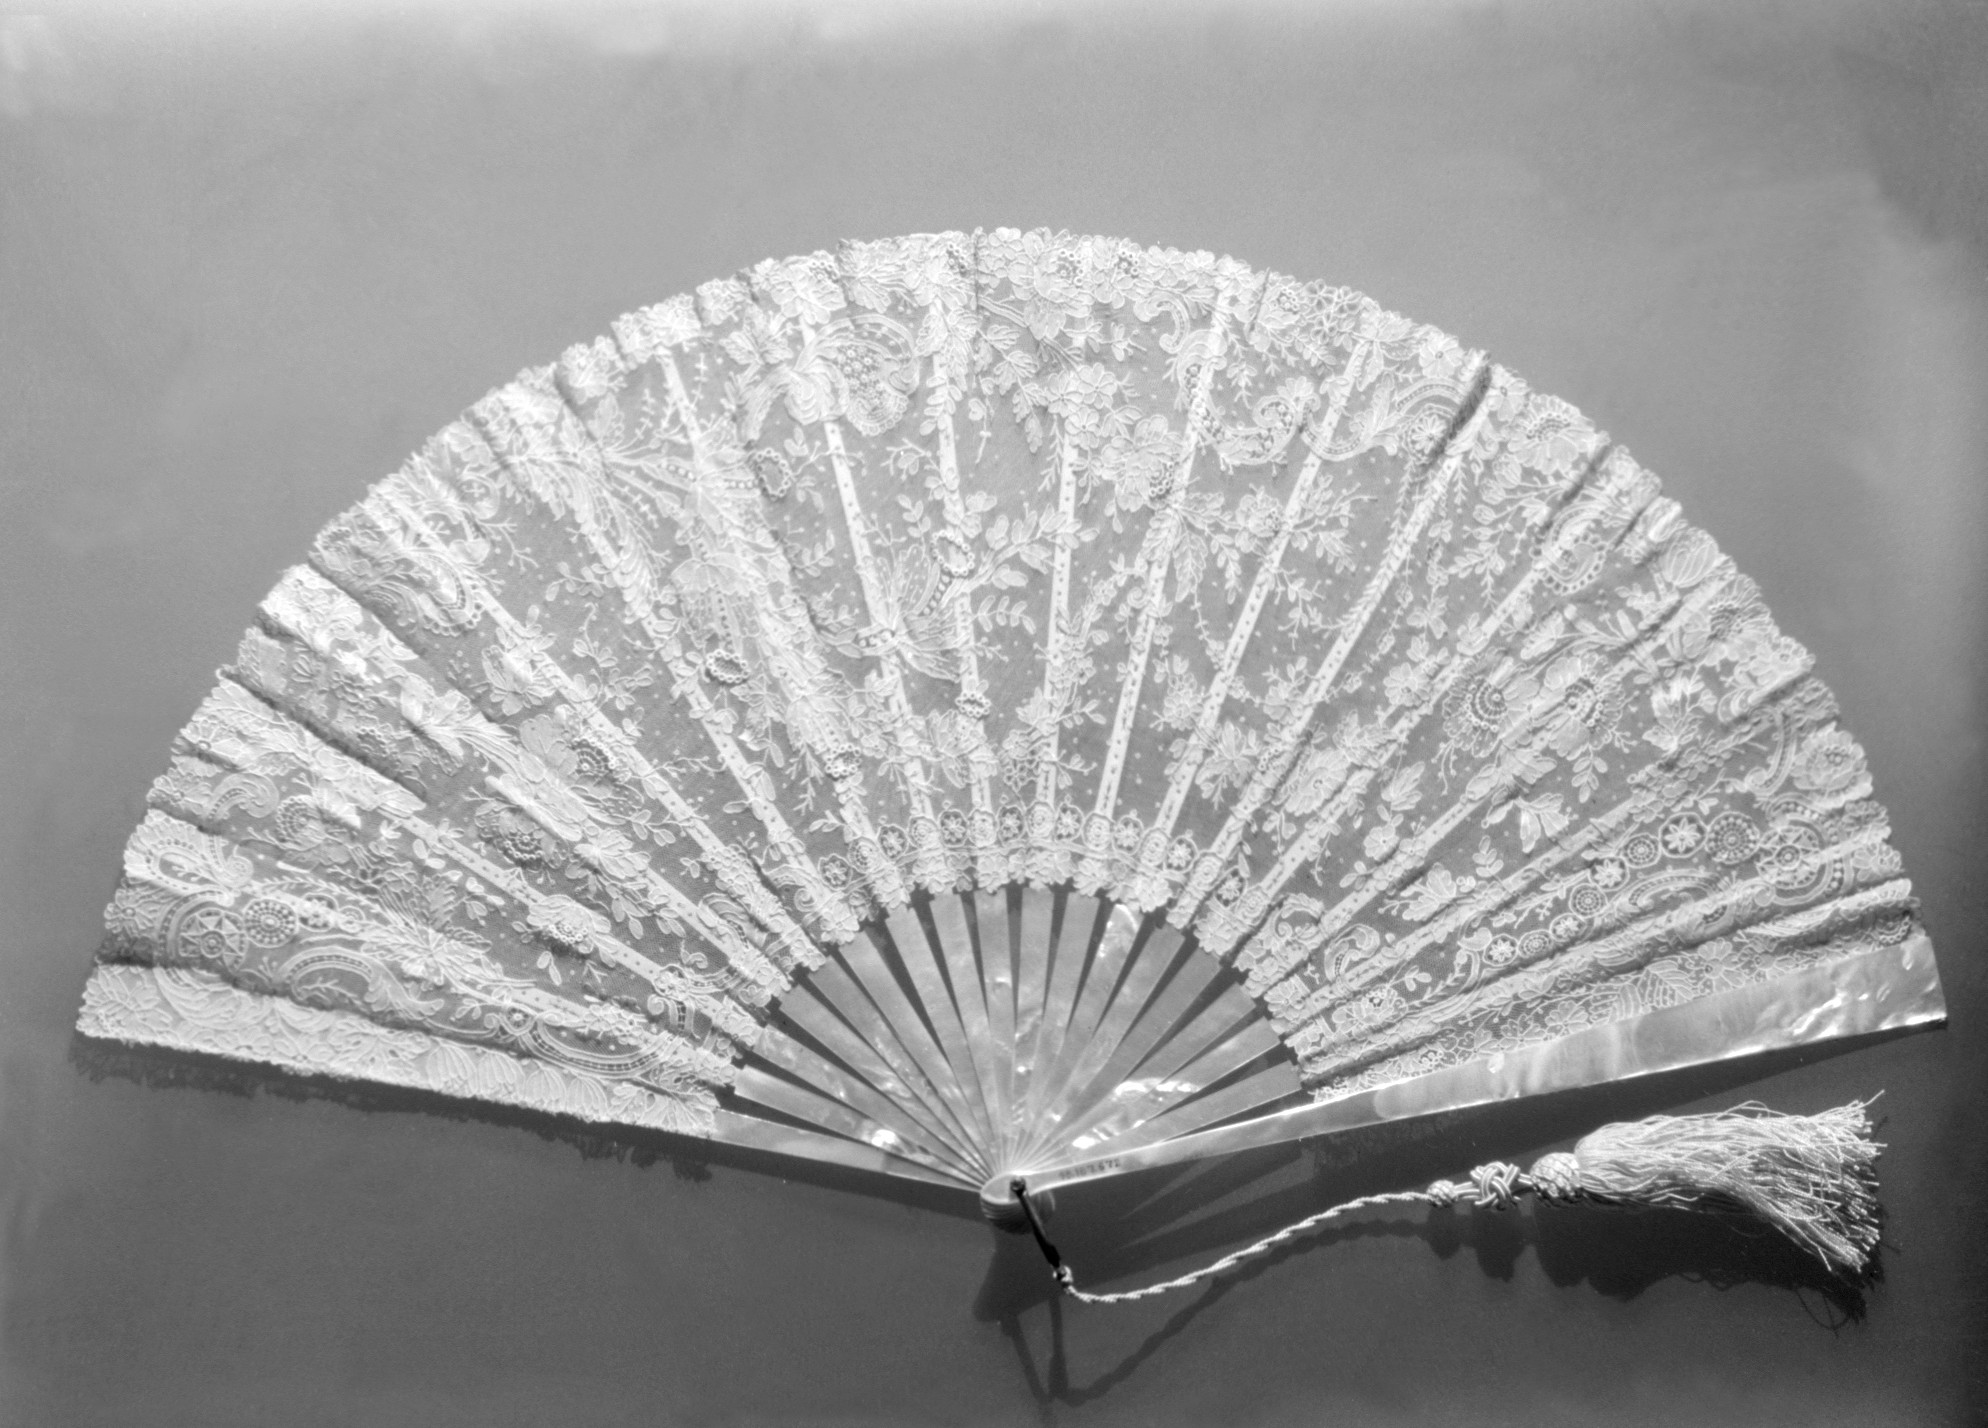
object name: fan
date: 1867-1900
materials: lace, mother of pearl, silk